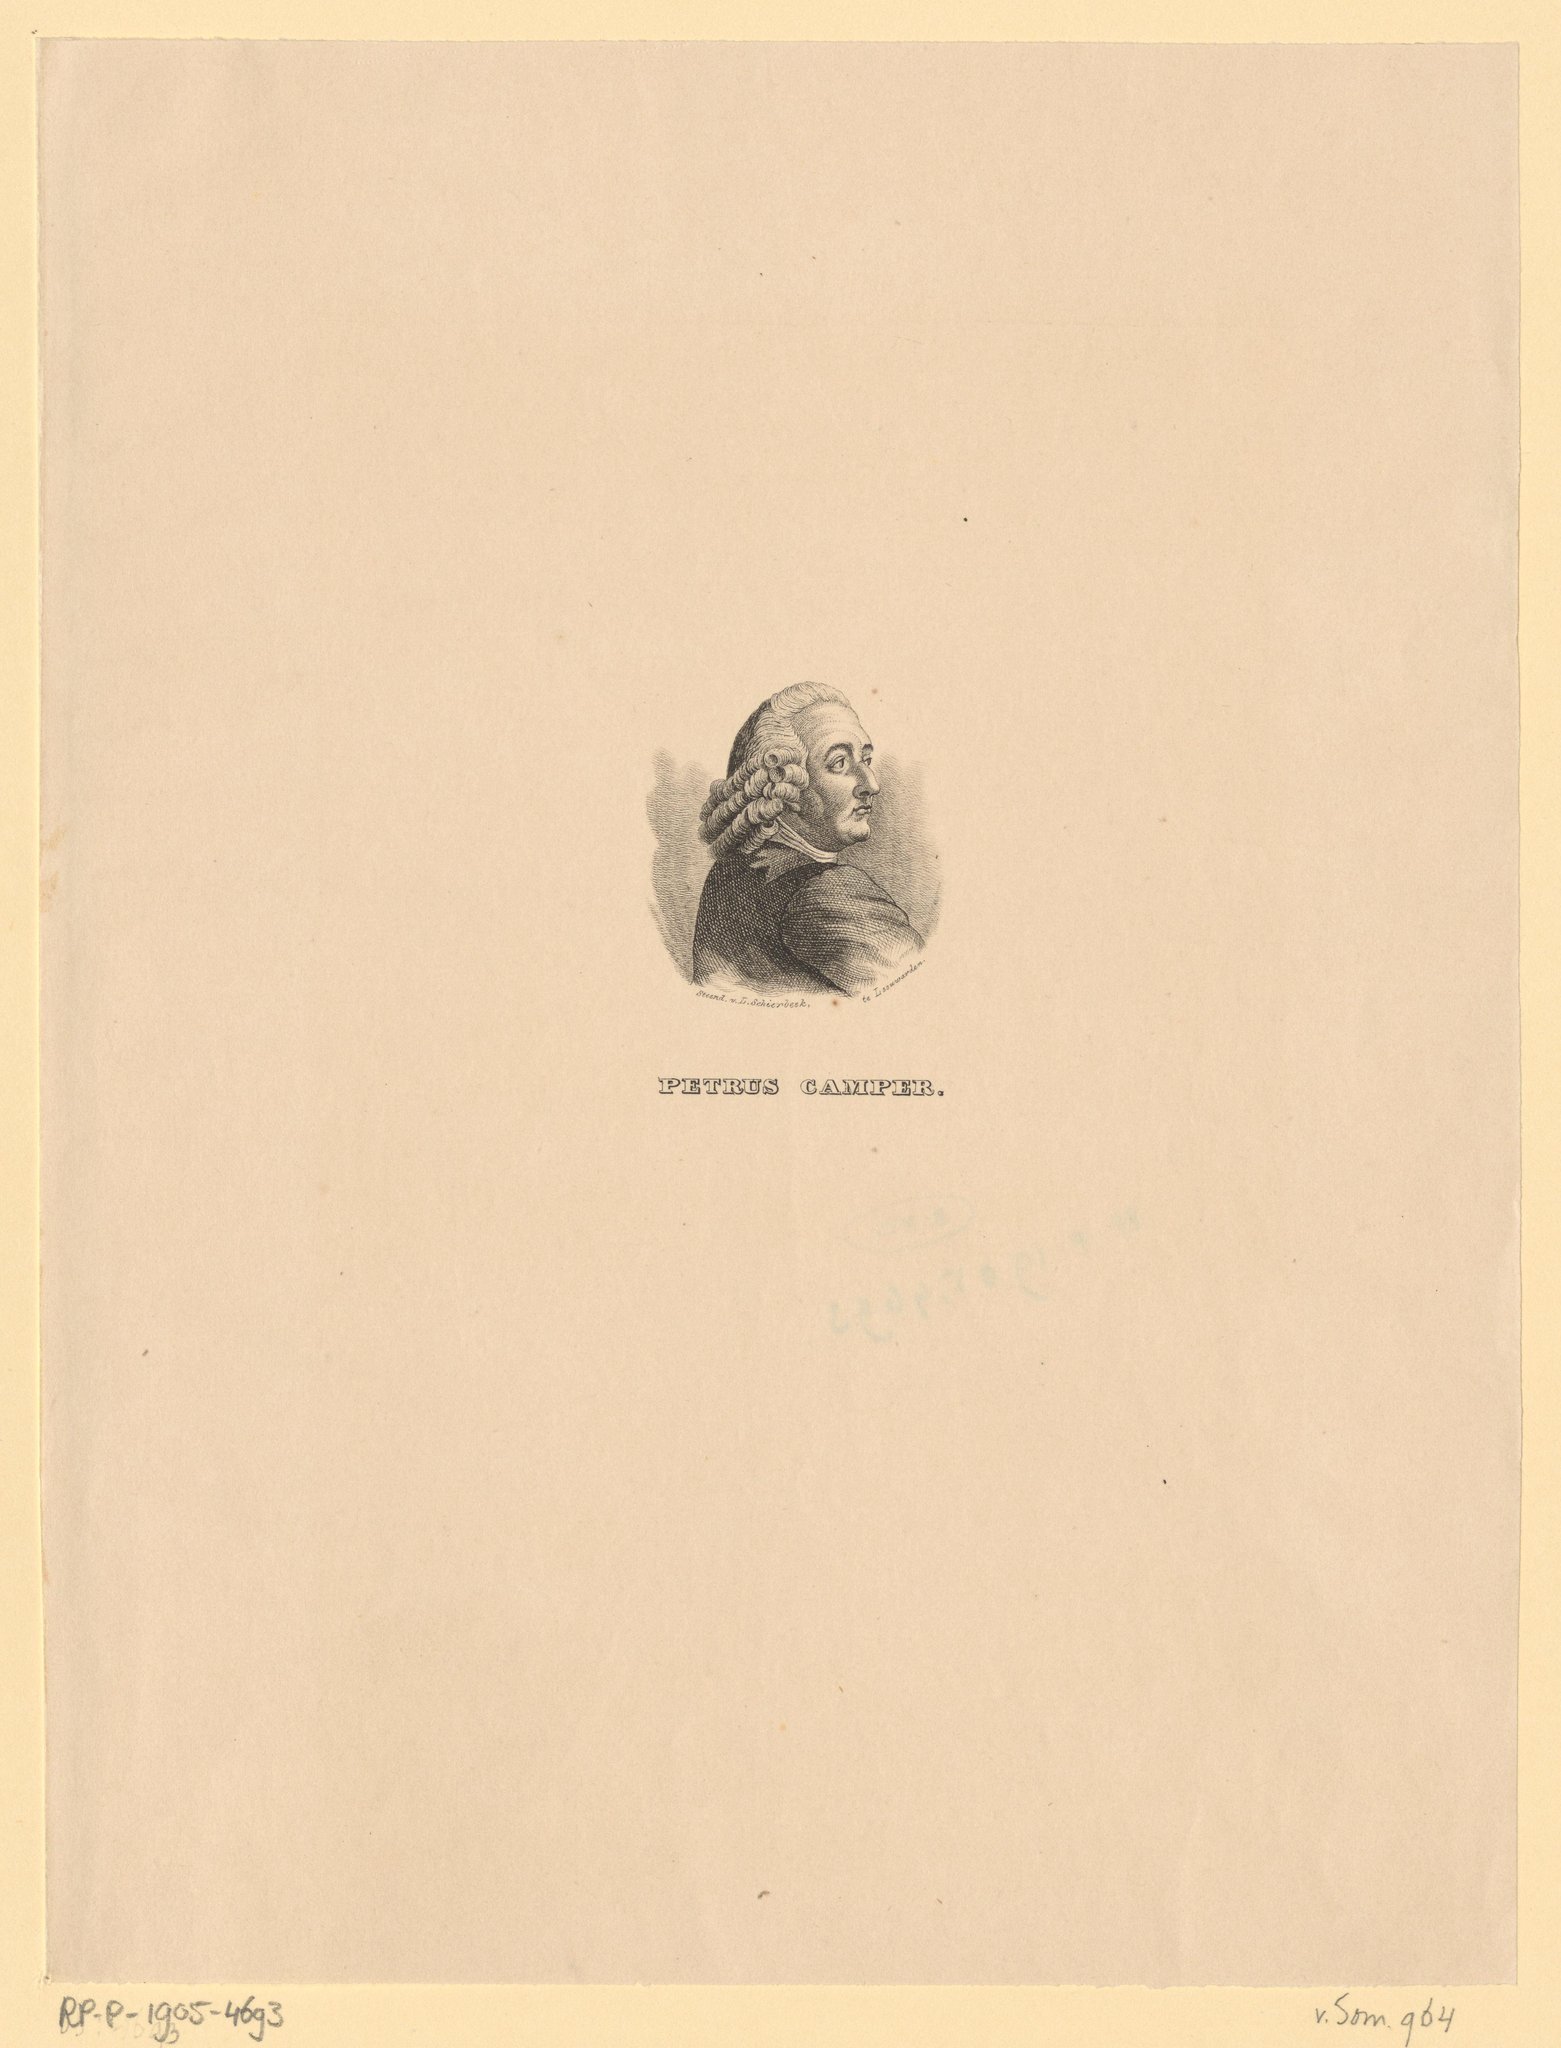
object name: print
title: Portret van Petrus Camper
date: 1823-1850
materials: paper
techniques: lithograph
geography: leeuwarden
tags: petrus camper, historical persons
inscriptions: collector's mark: Lugt 2228